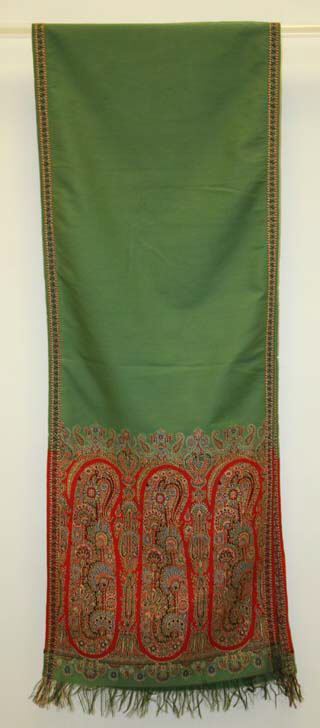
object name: scarf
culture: french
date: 1801-1833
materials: wool